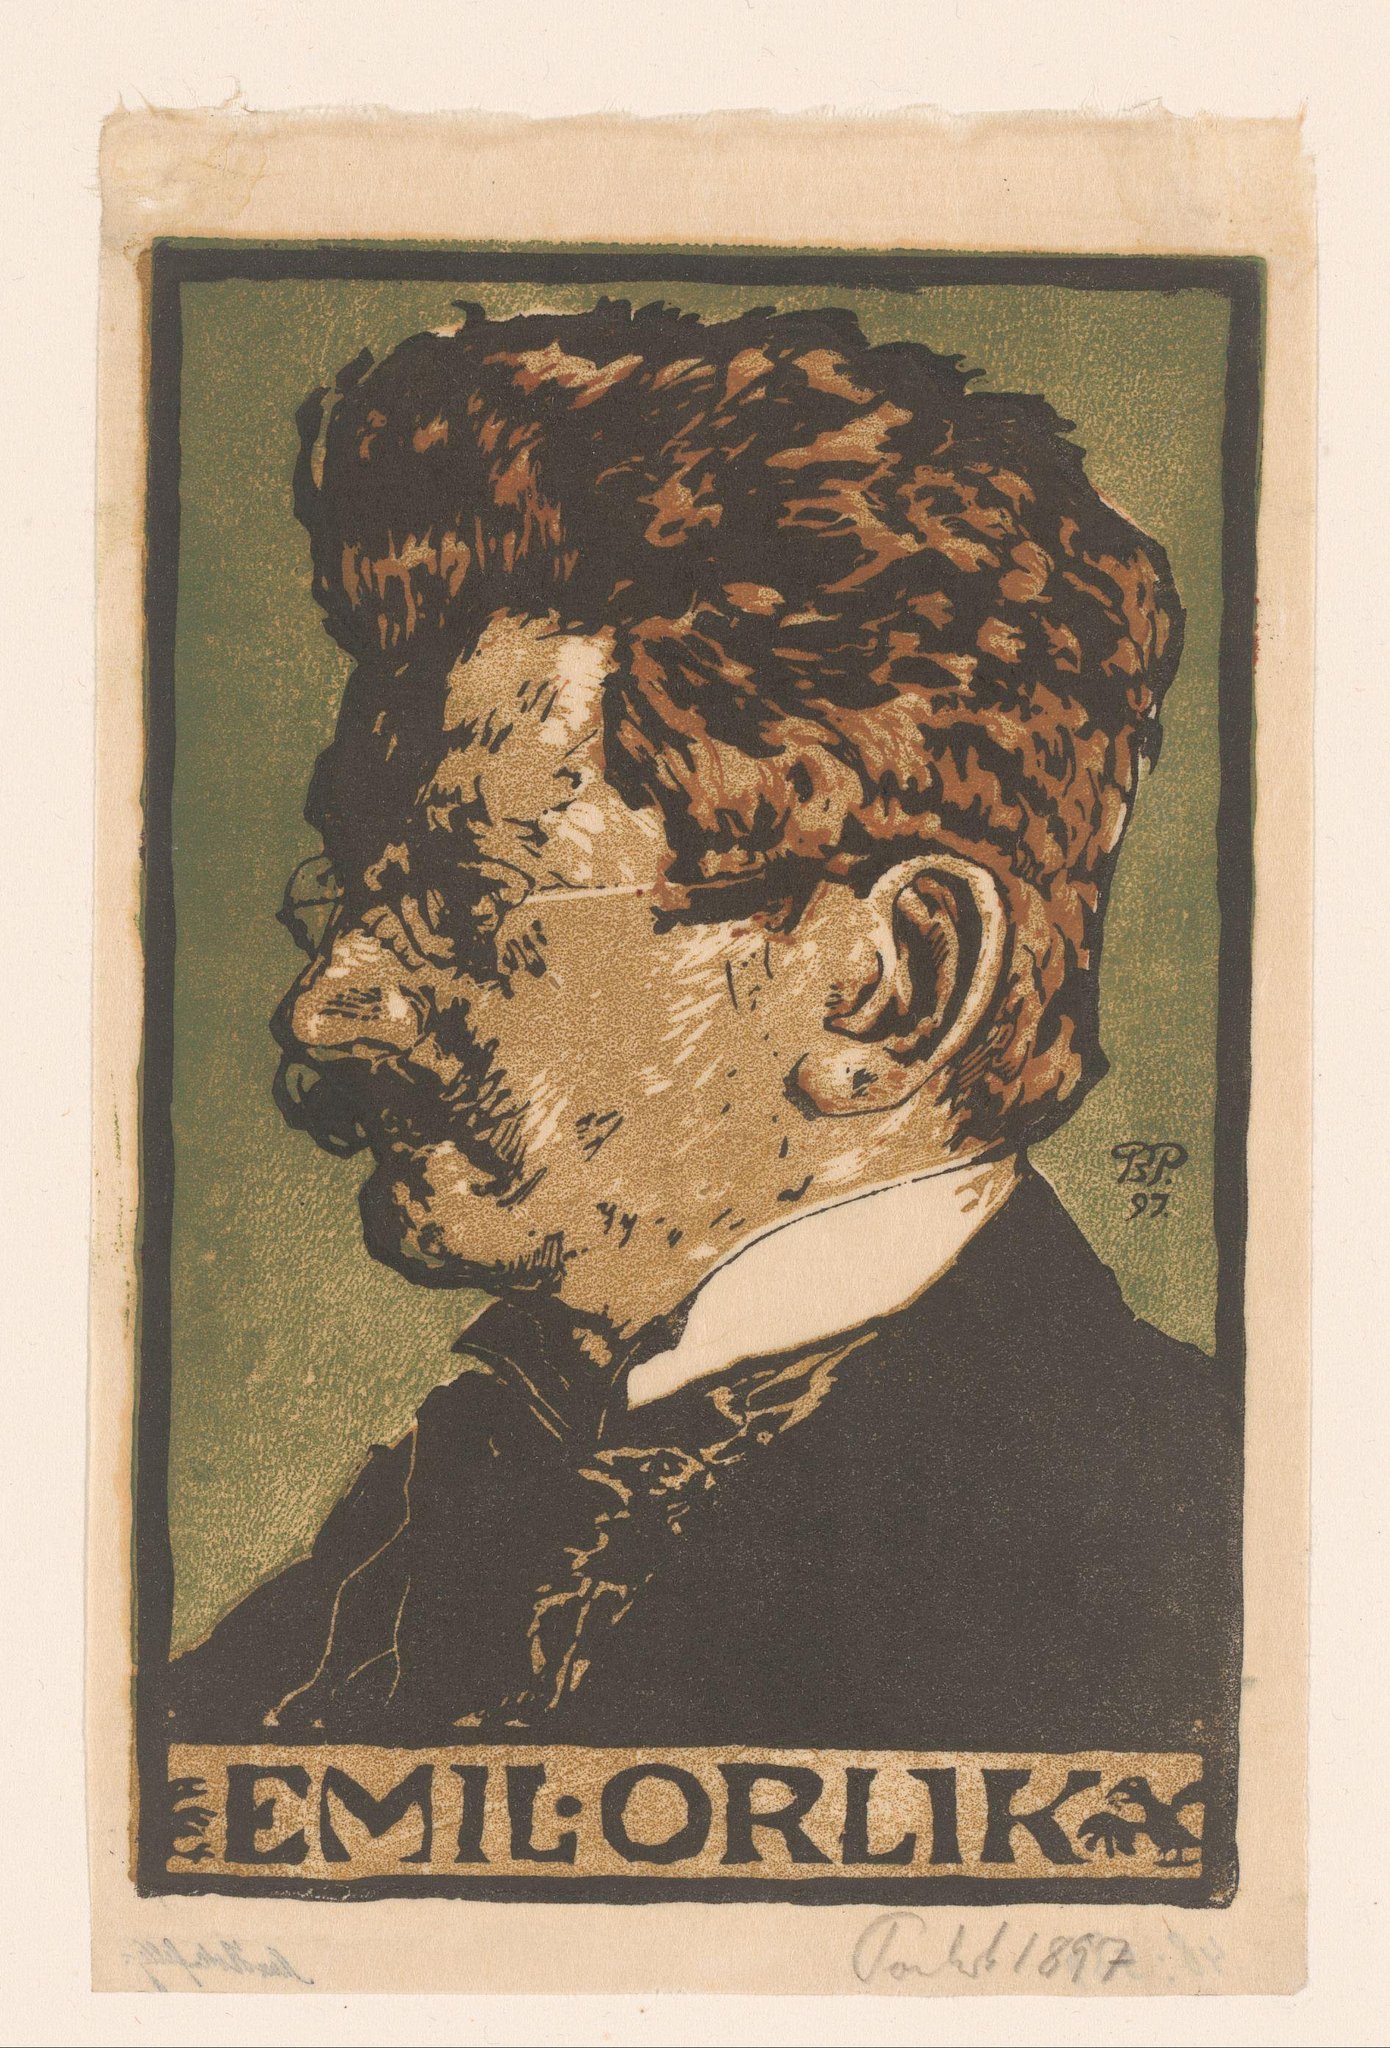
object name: print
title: Portret van Emil Orlik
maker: bernhard pankok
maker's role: print maker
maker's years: 1872-1943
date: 1897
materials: paper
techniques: woodcut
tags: prague, painter, print maker, emil orlik, portrait, self-portrait of artist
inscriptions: date